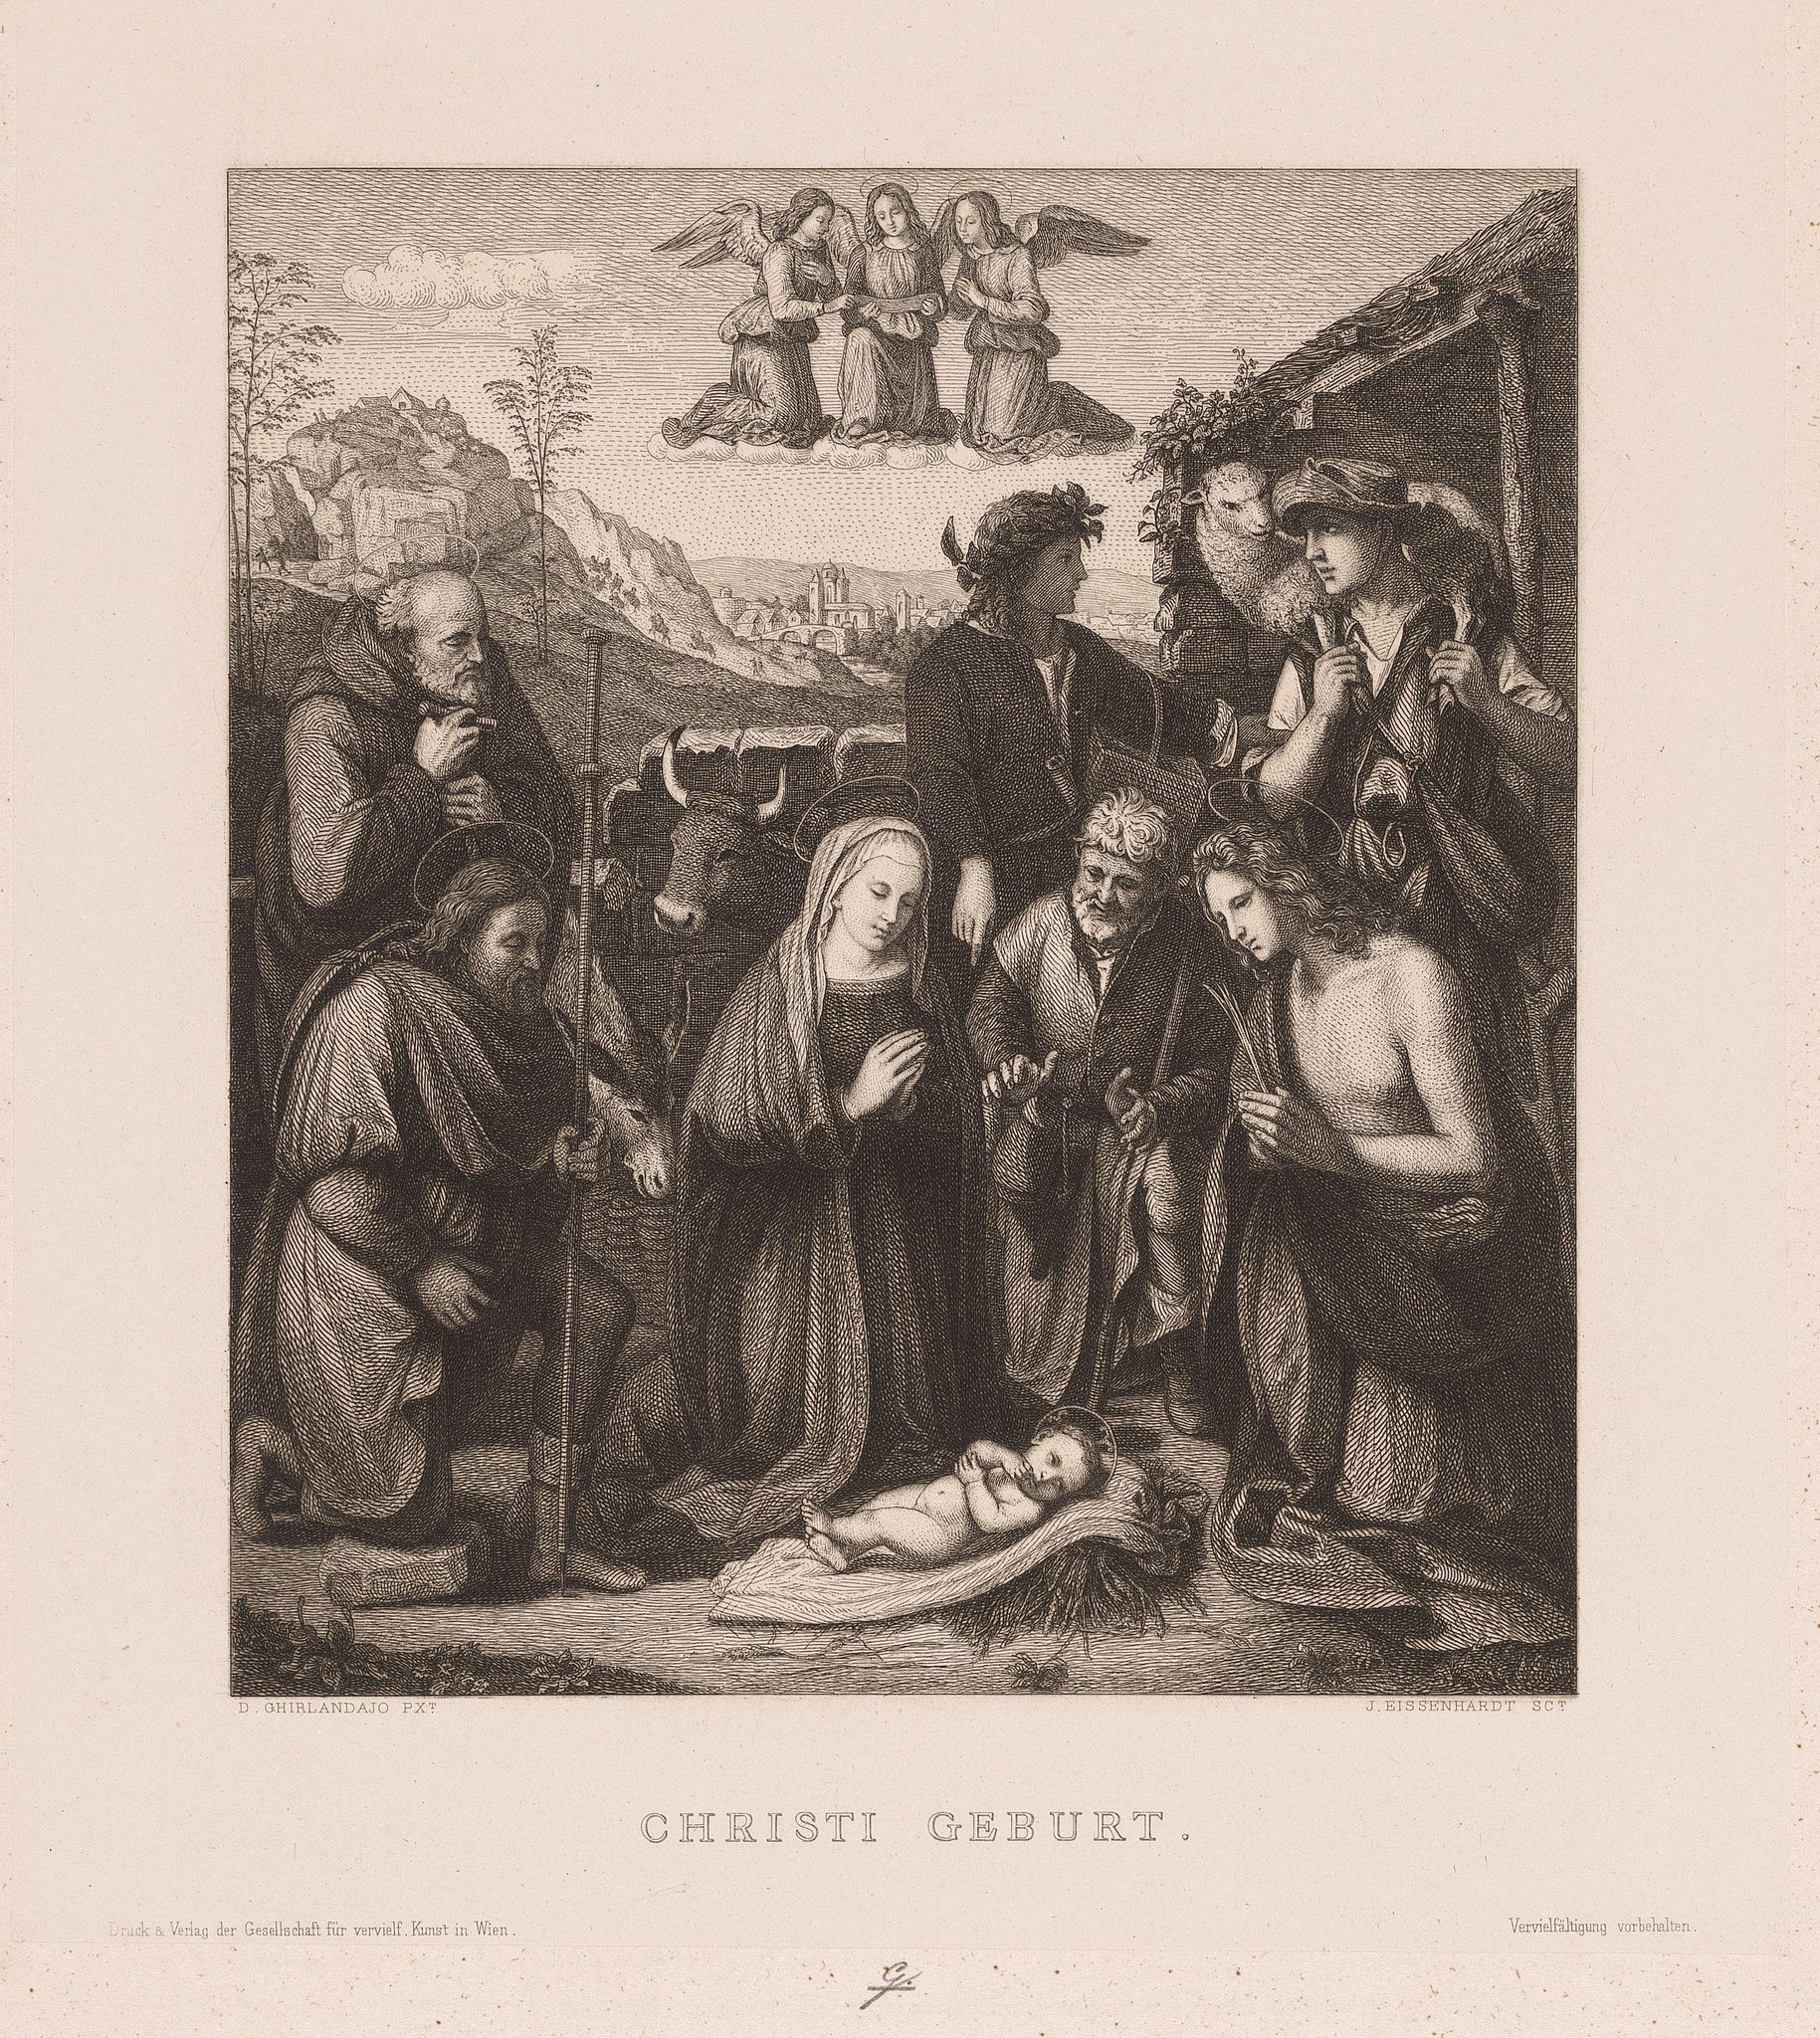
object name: print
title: Geboorte van Christus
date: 1834-1896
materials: paper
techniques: etching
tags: adoration of the christ-child ~ christ's birth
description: Prent gebruikt voor: Die vervielfältigende Kunst der Gegenwart (...). Wenen: Gesellschaft für vervielfältigende Kunst, 1887-1903.